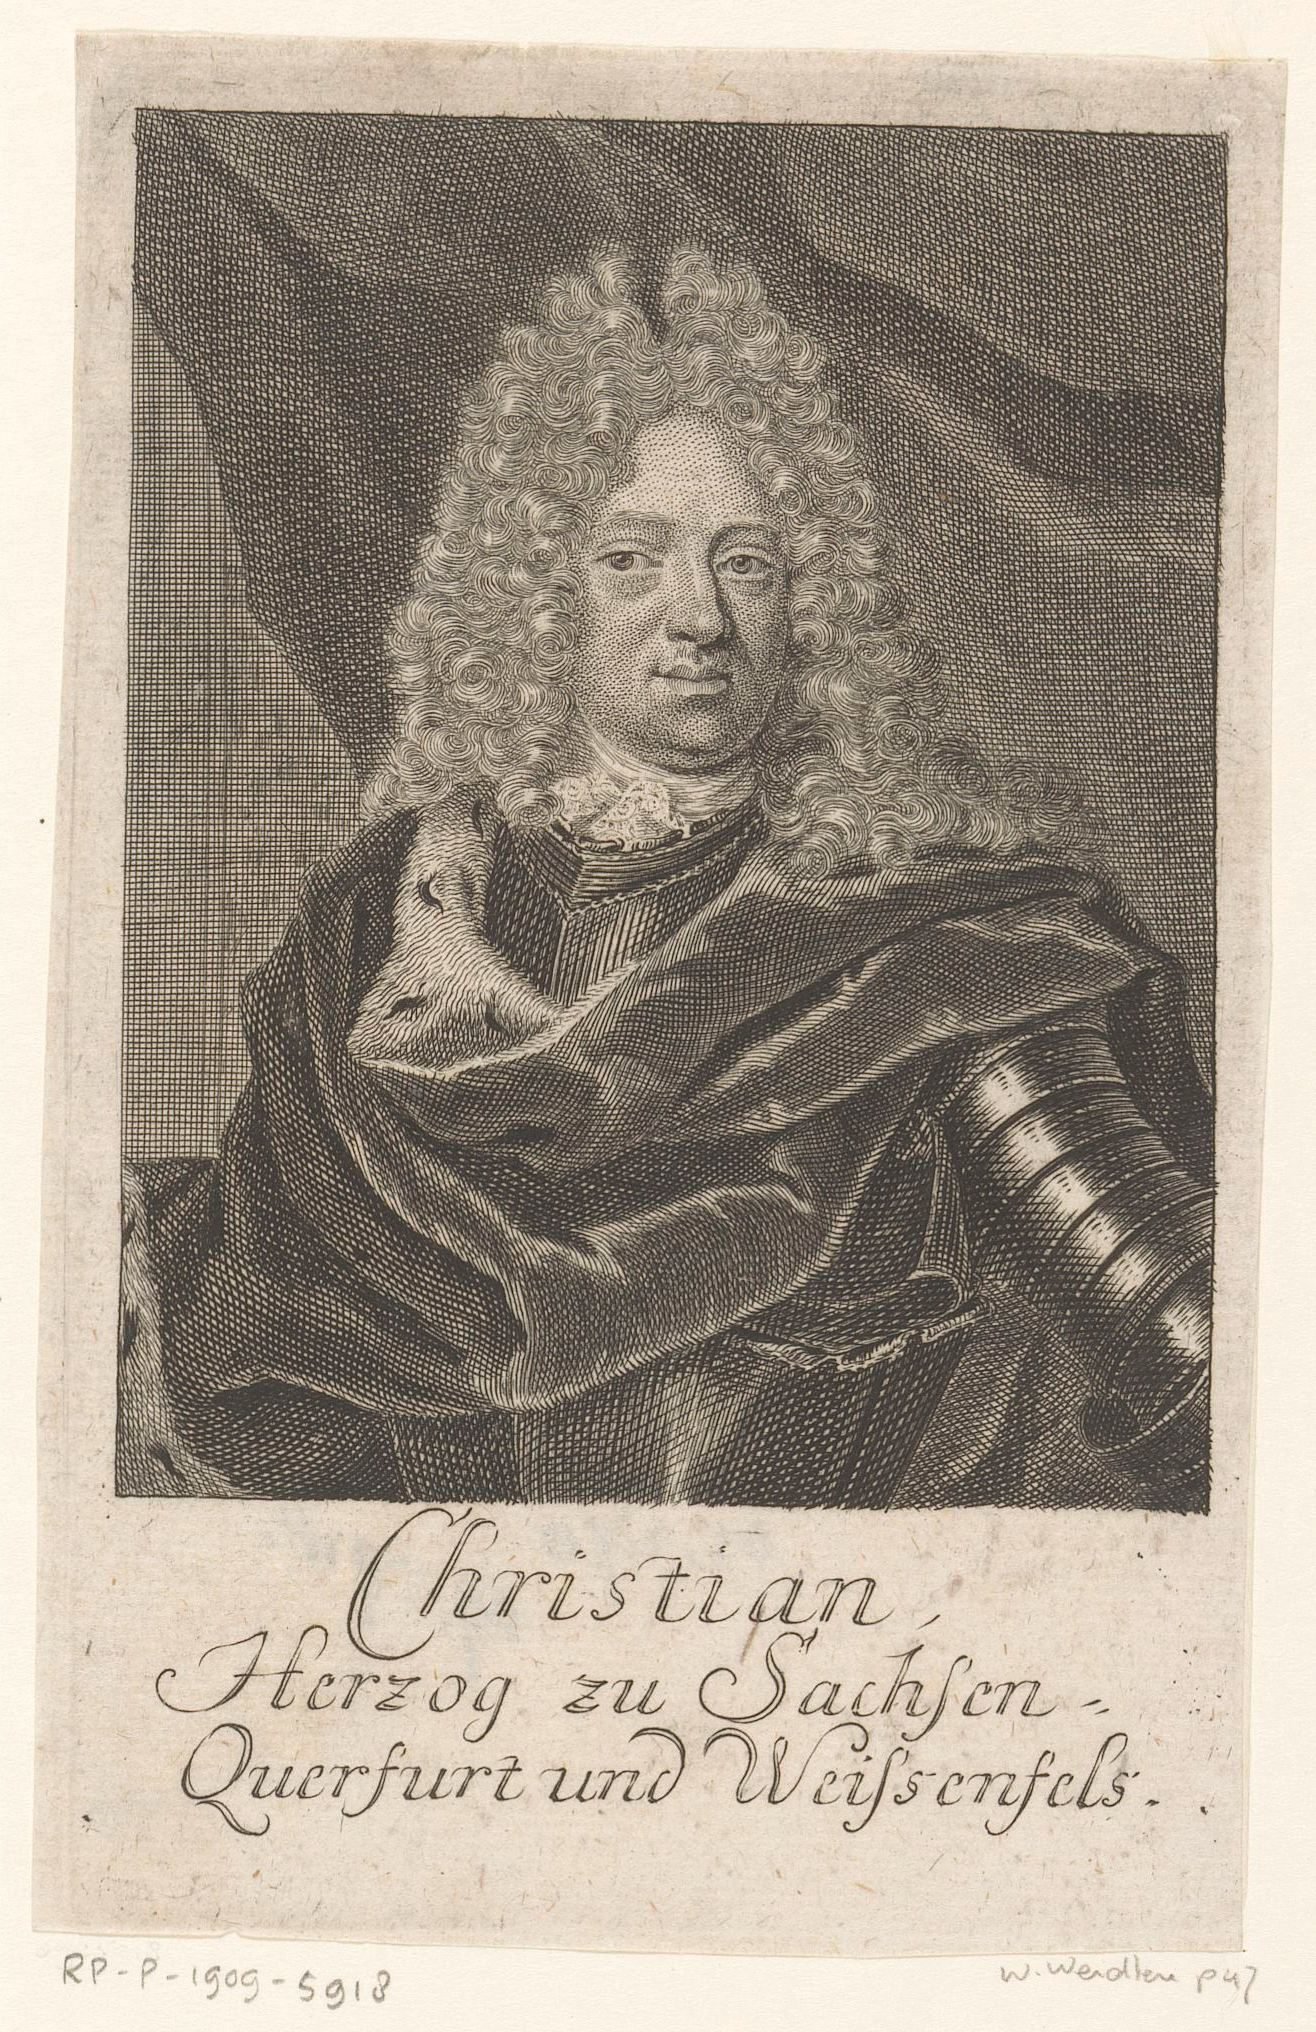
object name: print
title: Portret van Christian von Sachsen-Weißenfels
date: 1680-1767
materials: paper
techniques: engraving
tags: armour, historical persons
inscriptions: collector's mark: Lugt 2228